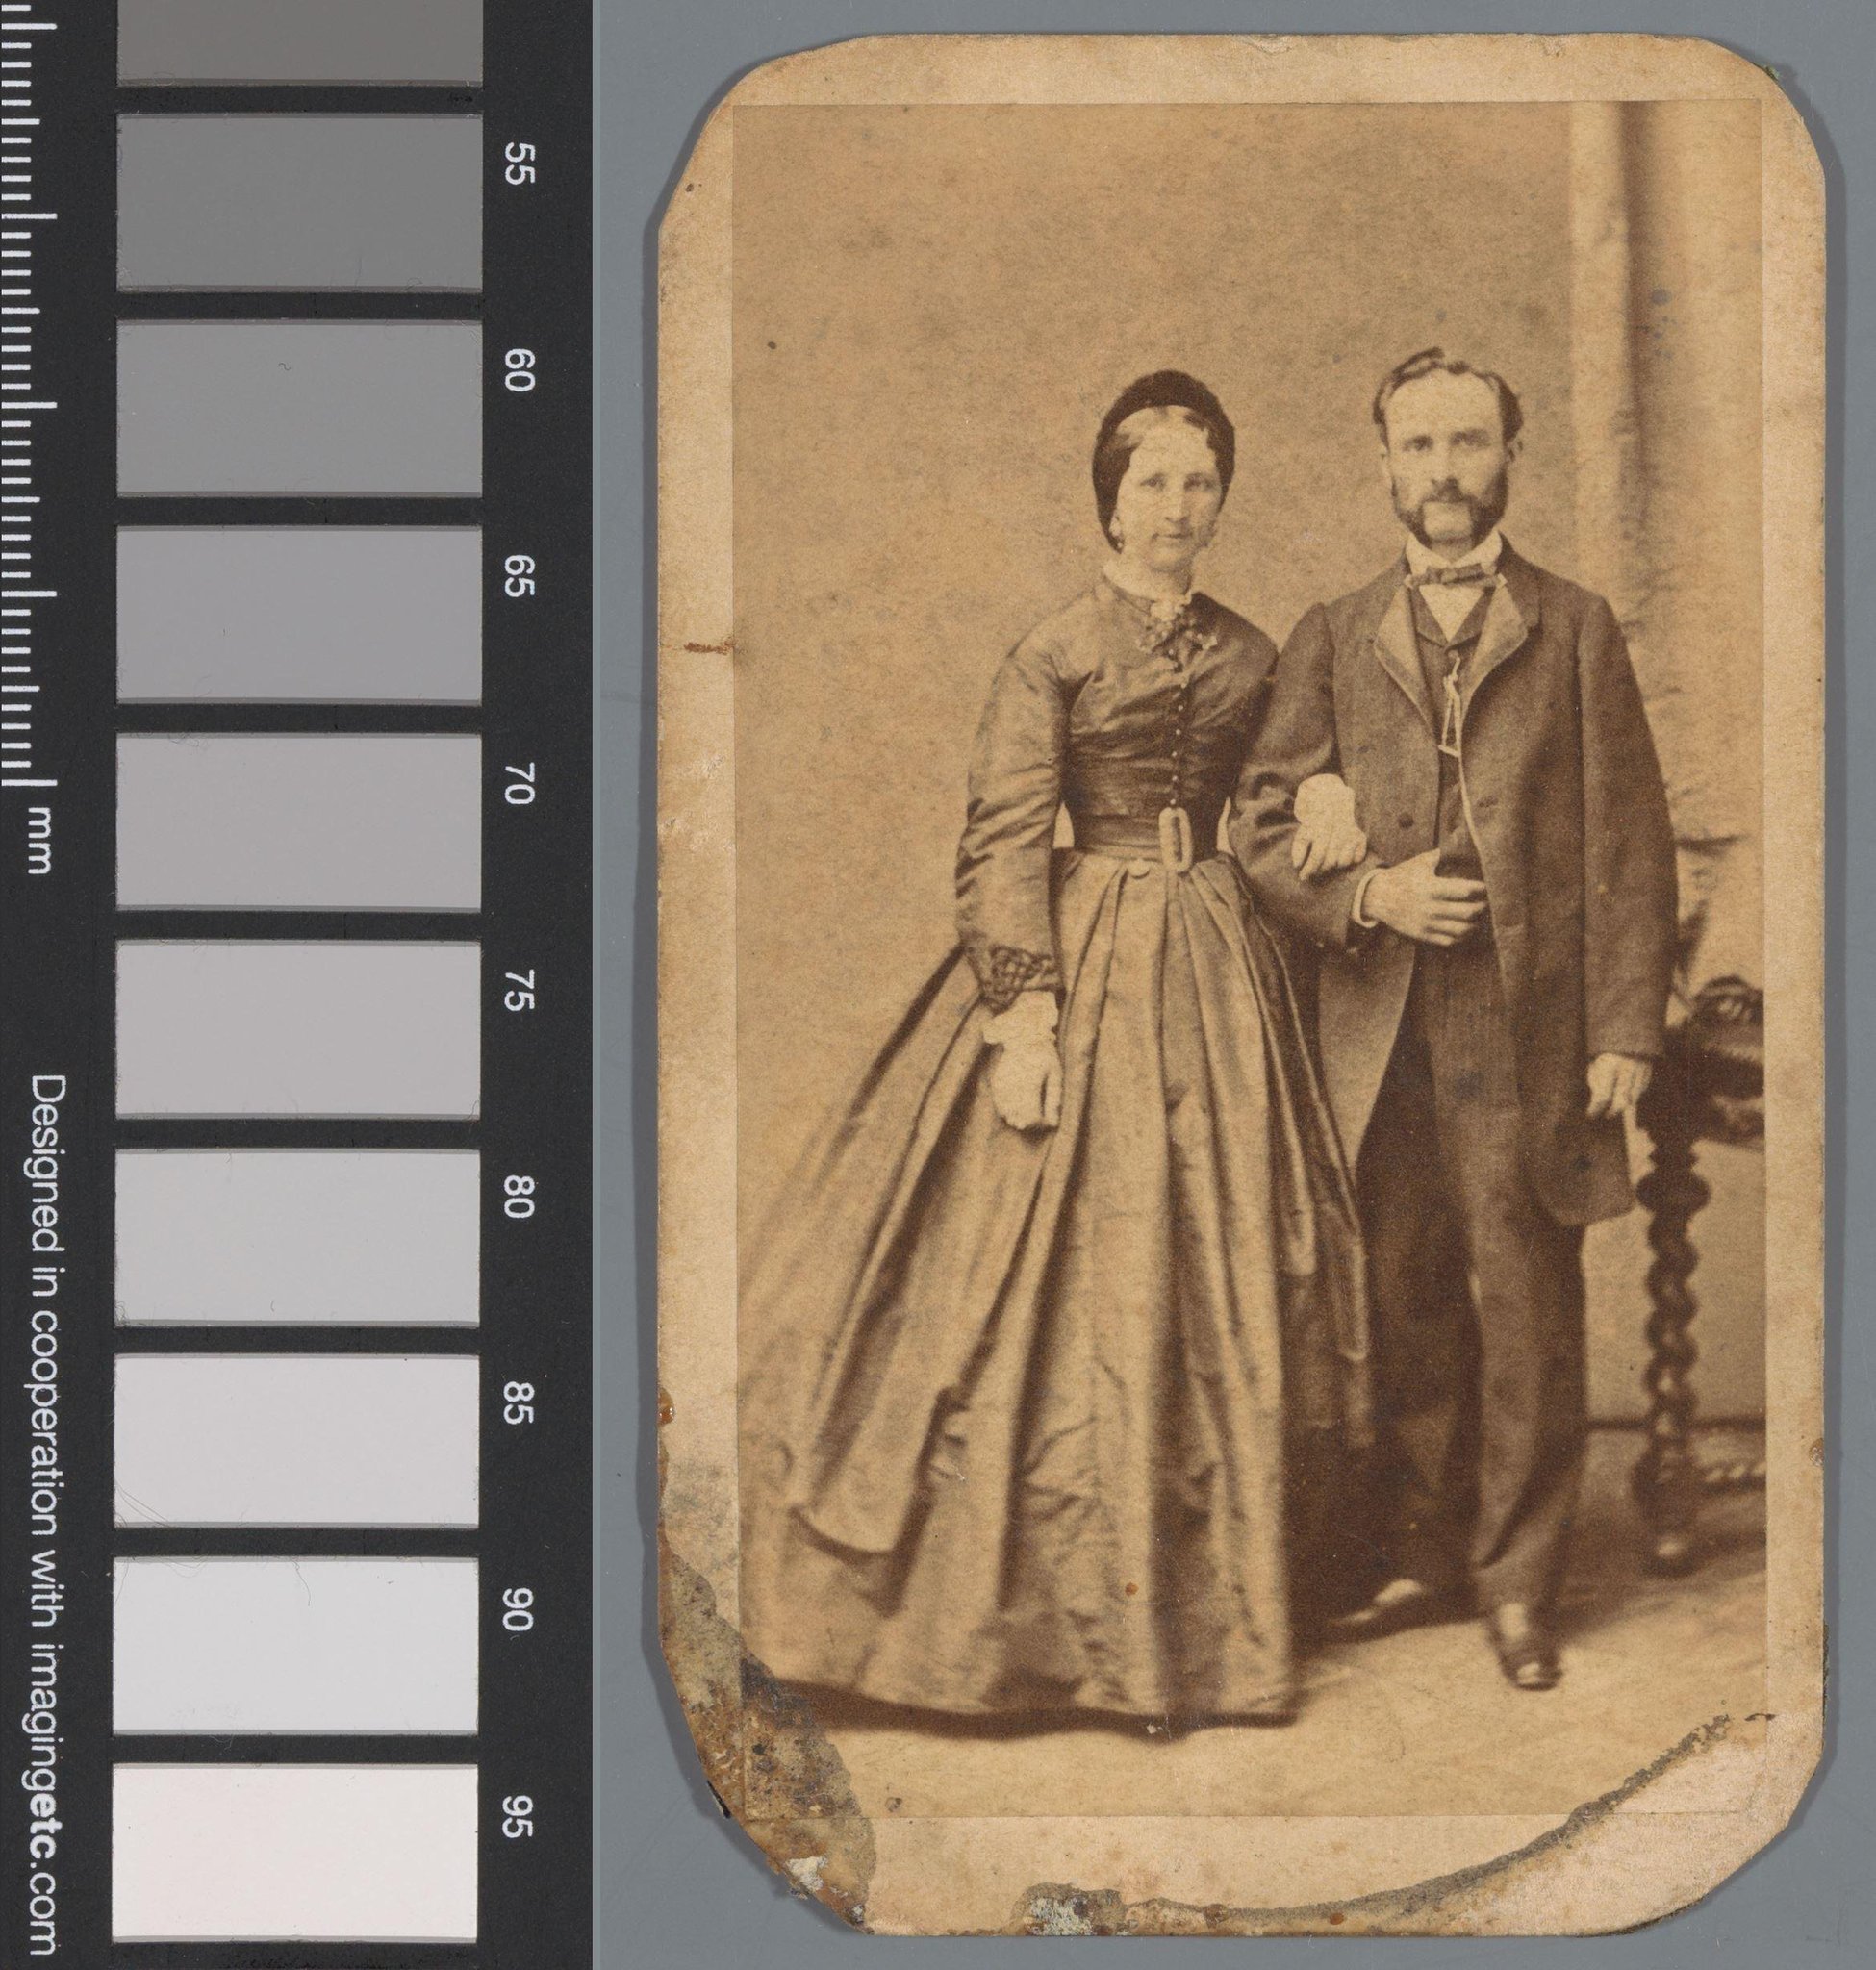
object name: photograph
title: Portret van het echtpaar Nopper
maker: heinrich daseking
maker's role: fotograaf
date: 1863-1901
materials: cardboard, paper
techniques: albumen print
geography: oldenburg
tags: historical persons, couple of lovers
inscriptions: inscription: ‘H. Daseking/ Photograph/ Oldenburg.’, inscription: ‘broer vader L. Nopper’, inscription: ‘Mein bruder Theodor Nopper, frau Meta Nopper’